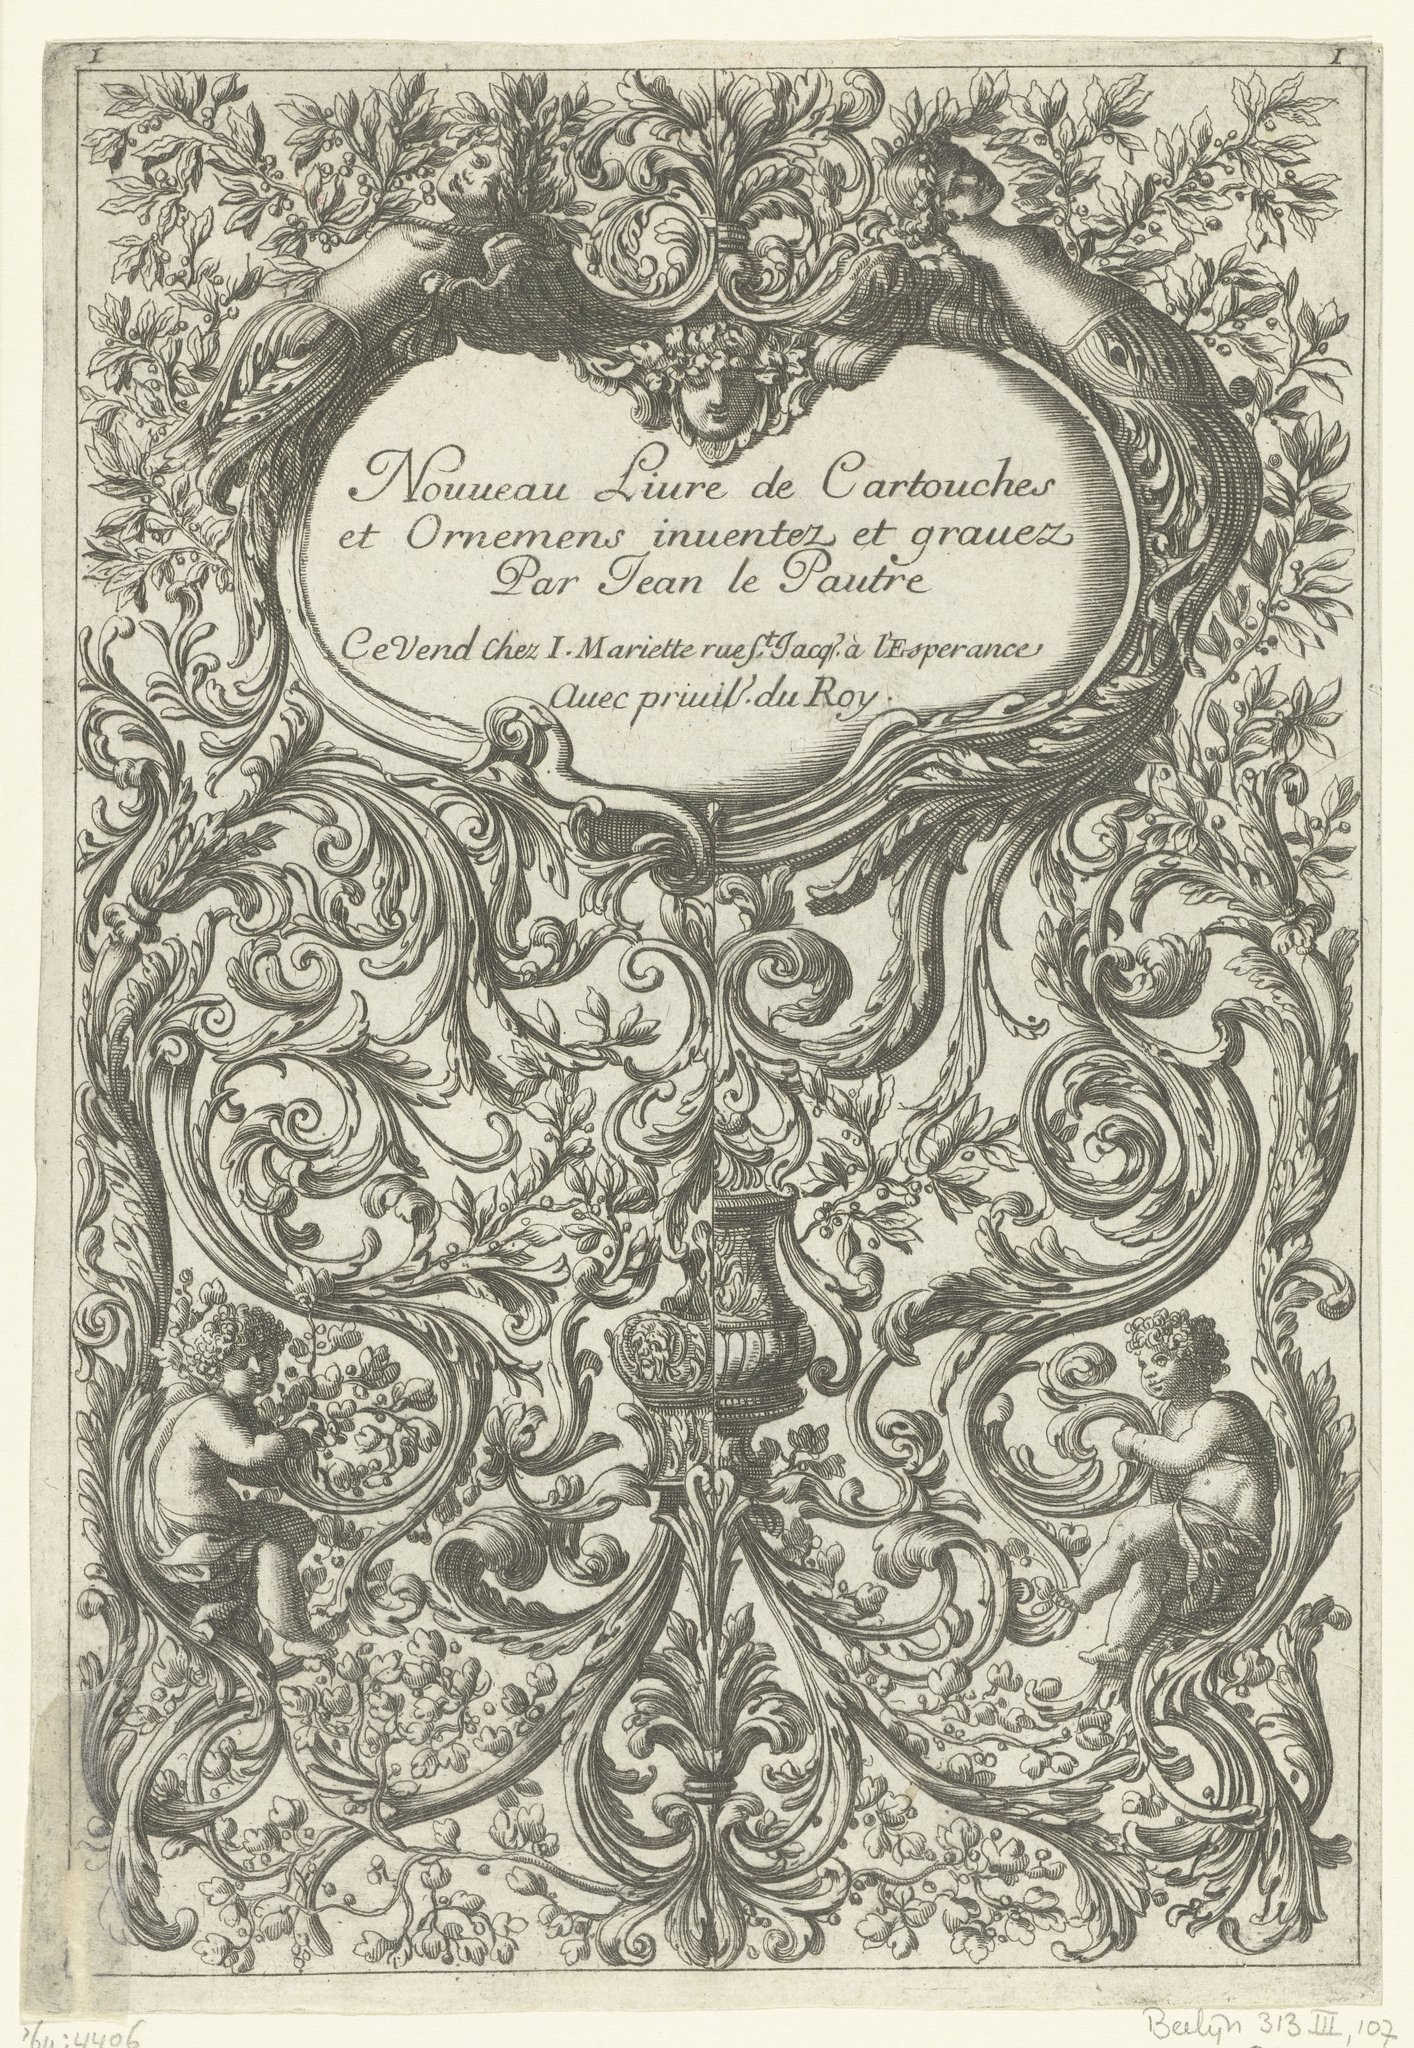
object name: ornament print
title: Titelblad: Nouueau Liure de Cartouches et Ornemens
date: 1682-1734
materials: paper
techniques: engraving, etching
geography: france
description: Twee half afgebeelde panelen, met bladranken en putti. Bovenaan staat de titel in een cartouche. Uit tweede editie.